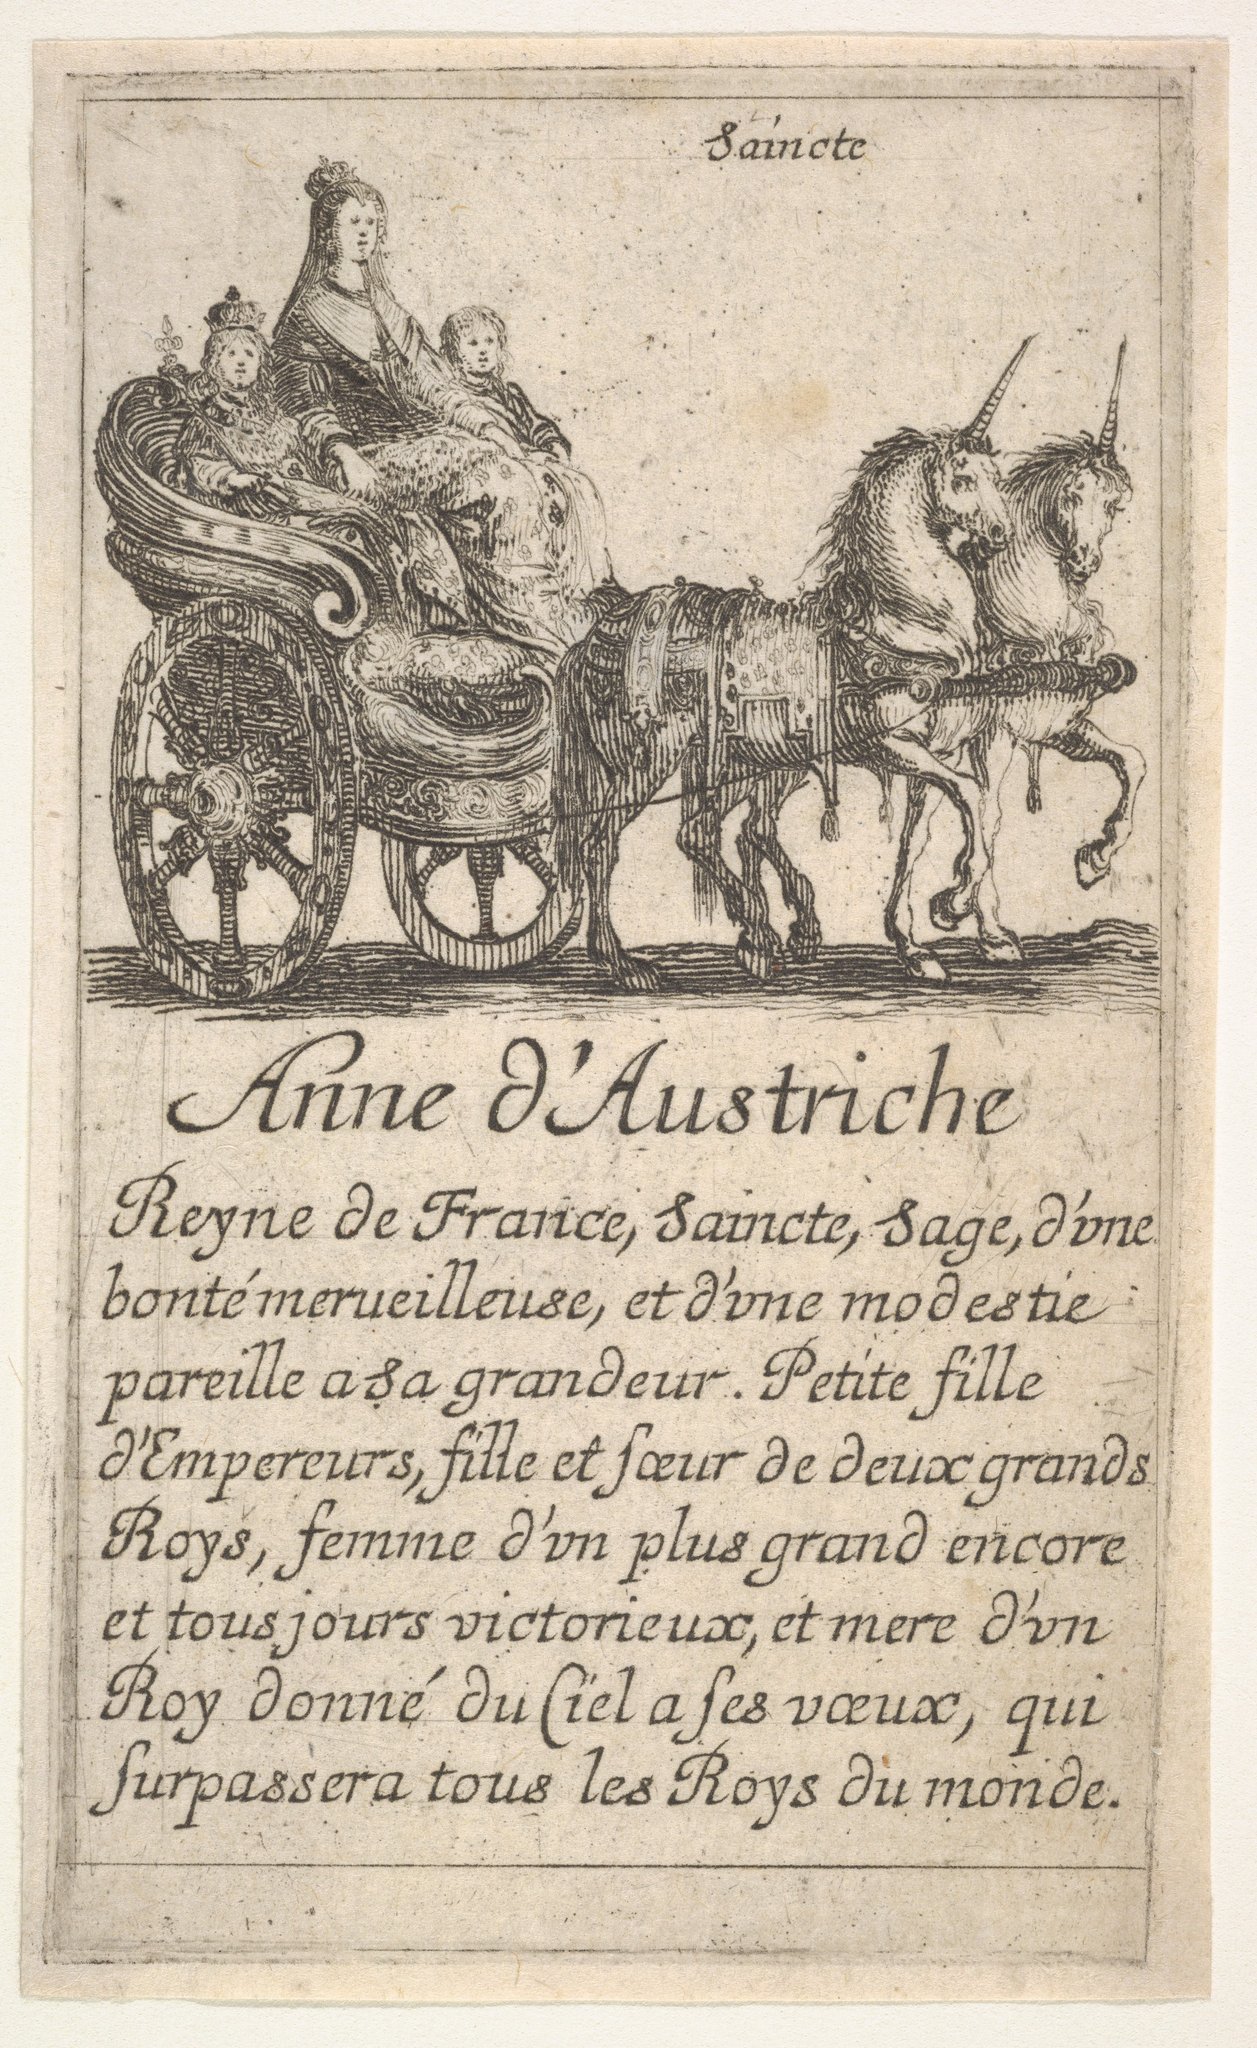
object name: print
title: Anne d'Austrische, from "The Game of Queens" (Le Jeu des Reines Renommées)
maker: stefano della bella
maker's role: artist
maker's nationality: italian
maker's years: 1610-1664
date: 1644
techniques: etching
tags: queens,girls,unicorns,carriages